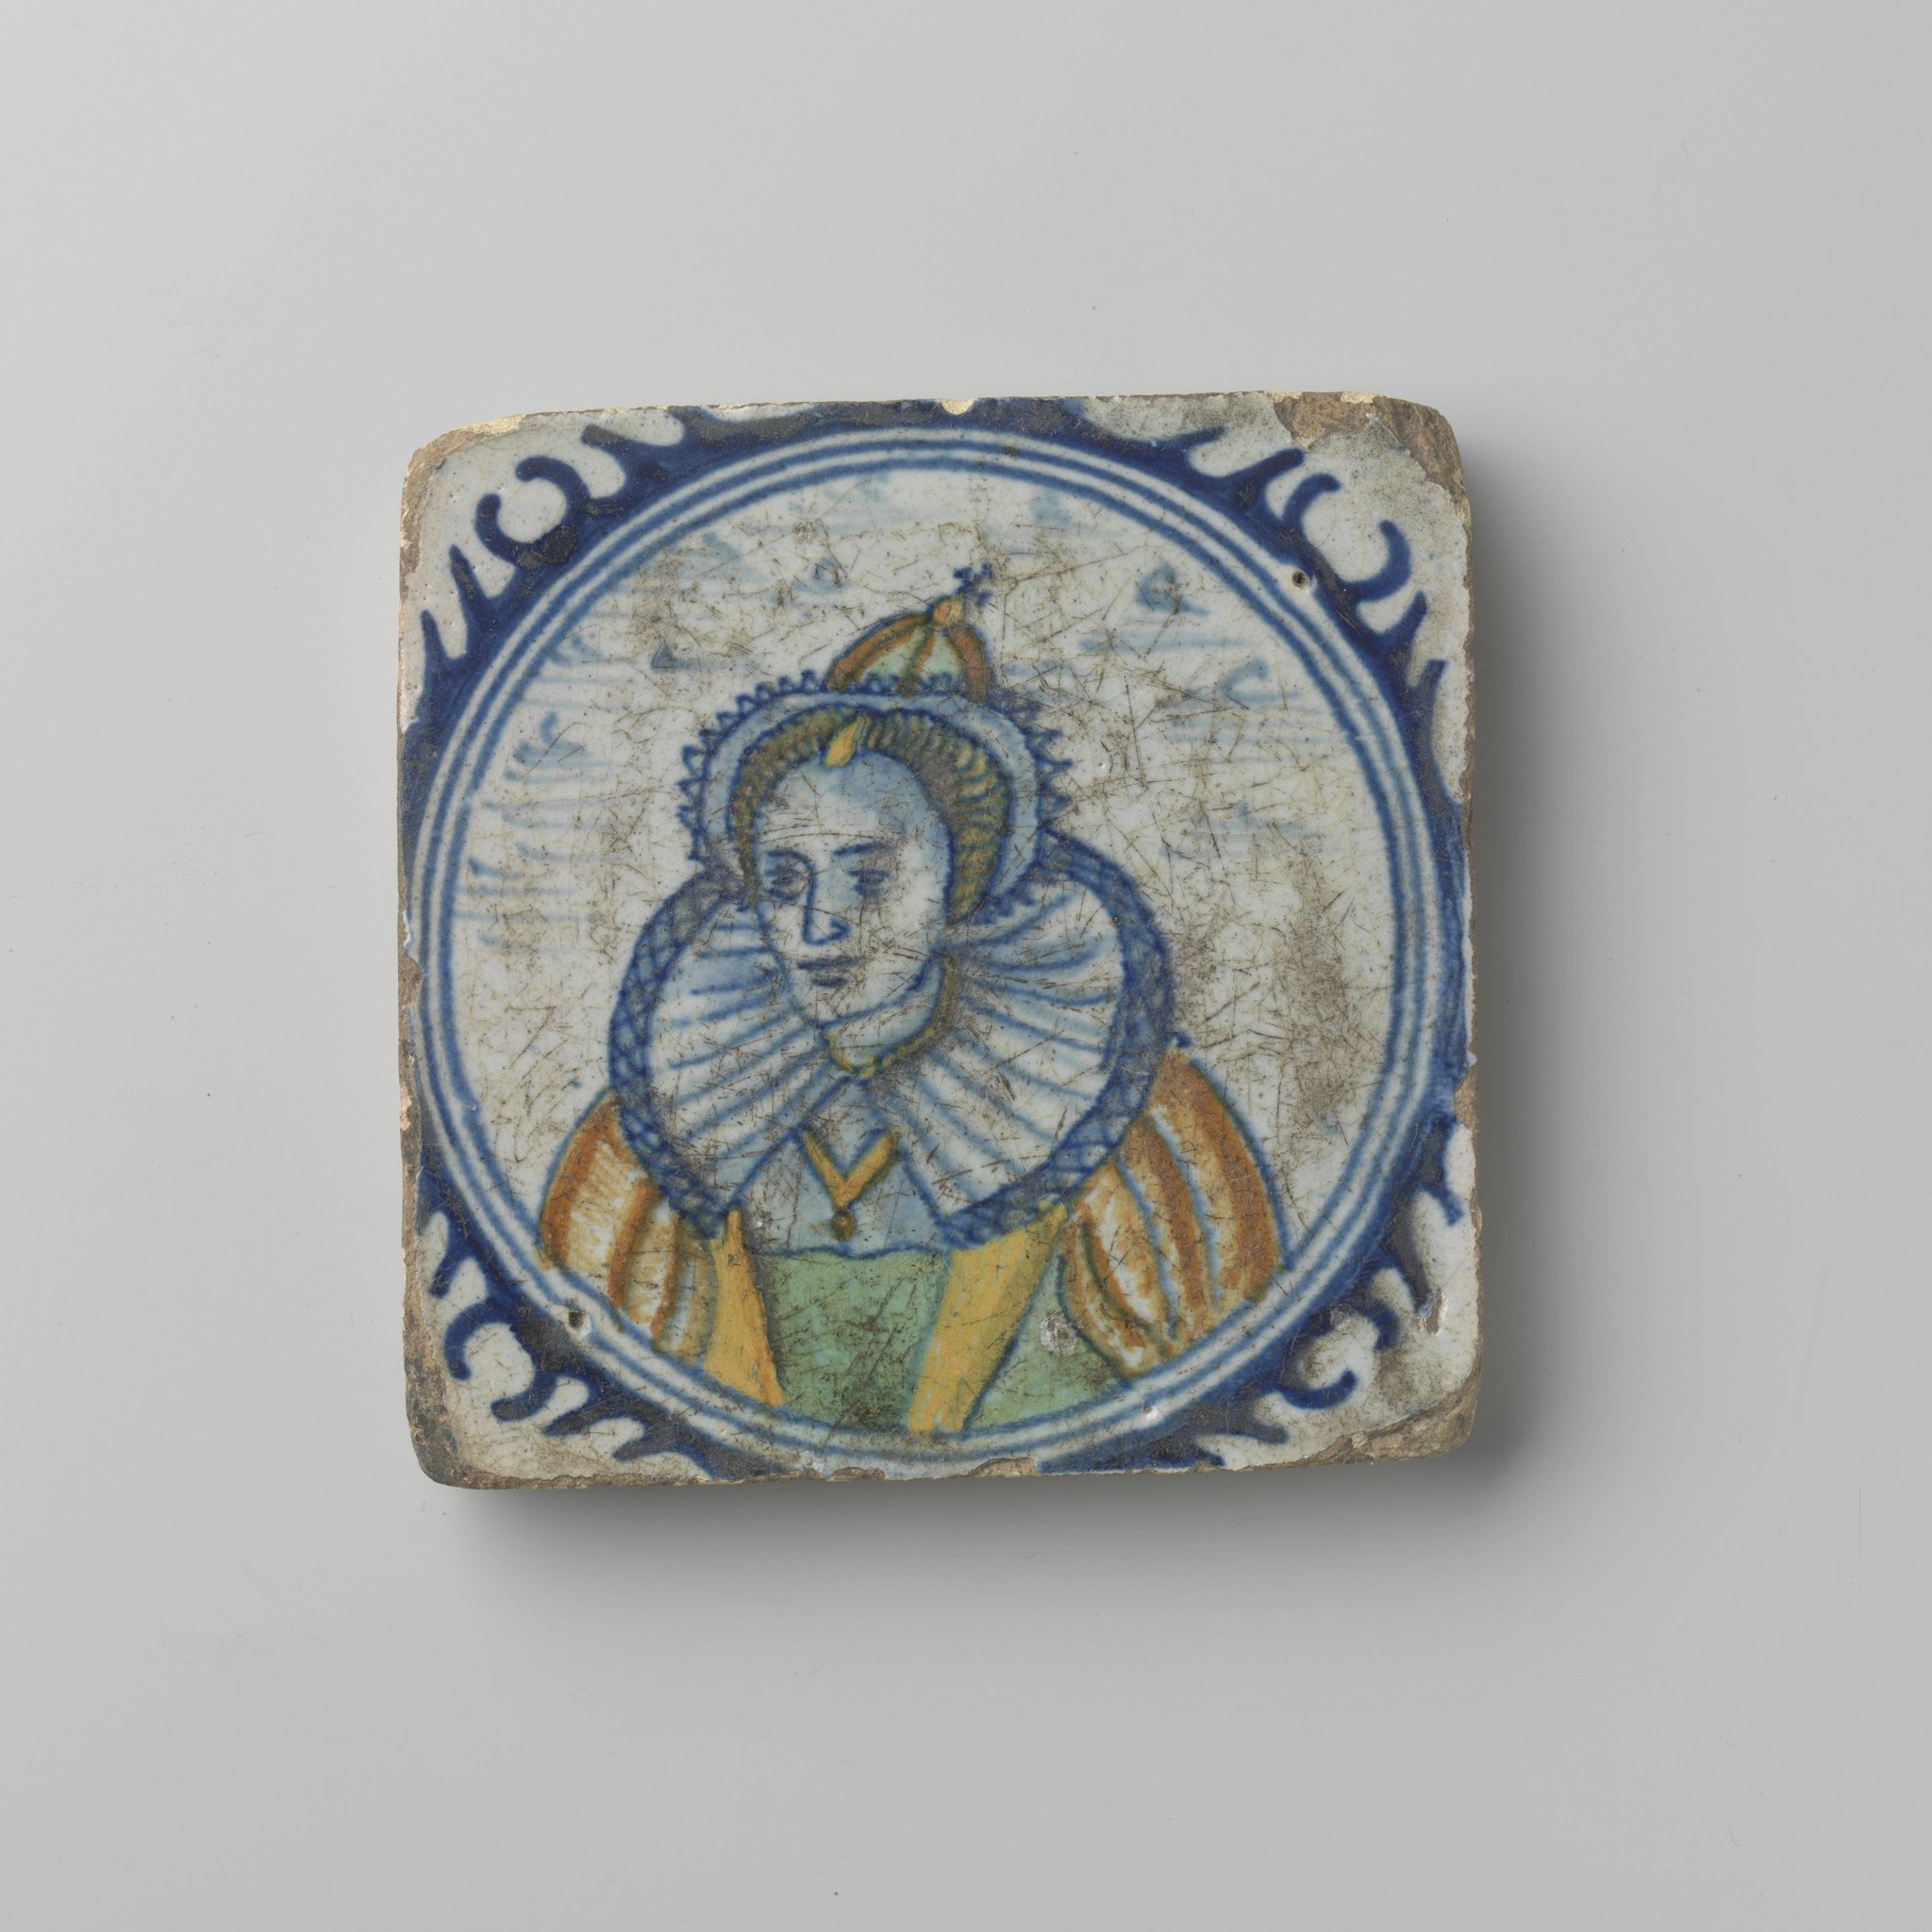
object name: tile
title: Tegel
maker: Anonymous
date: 1600-1625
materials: earthenware, glaze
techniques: maiolica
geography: great britain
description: Tegel met een veelkleurig (blauw, groen, geel en oranje) portret van koningin Elizabeth omlijst door een cirkel versierd bij de hoeken met vlammetjes.